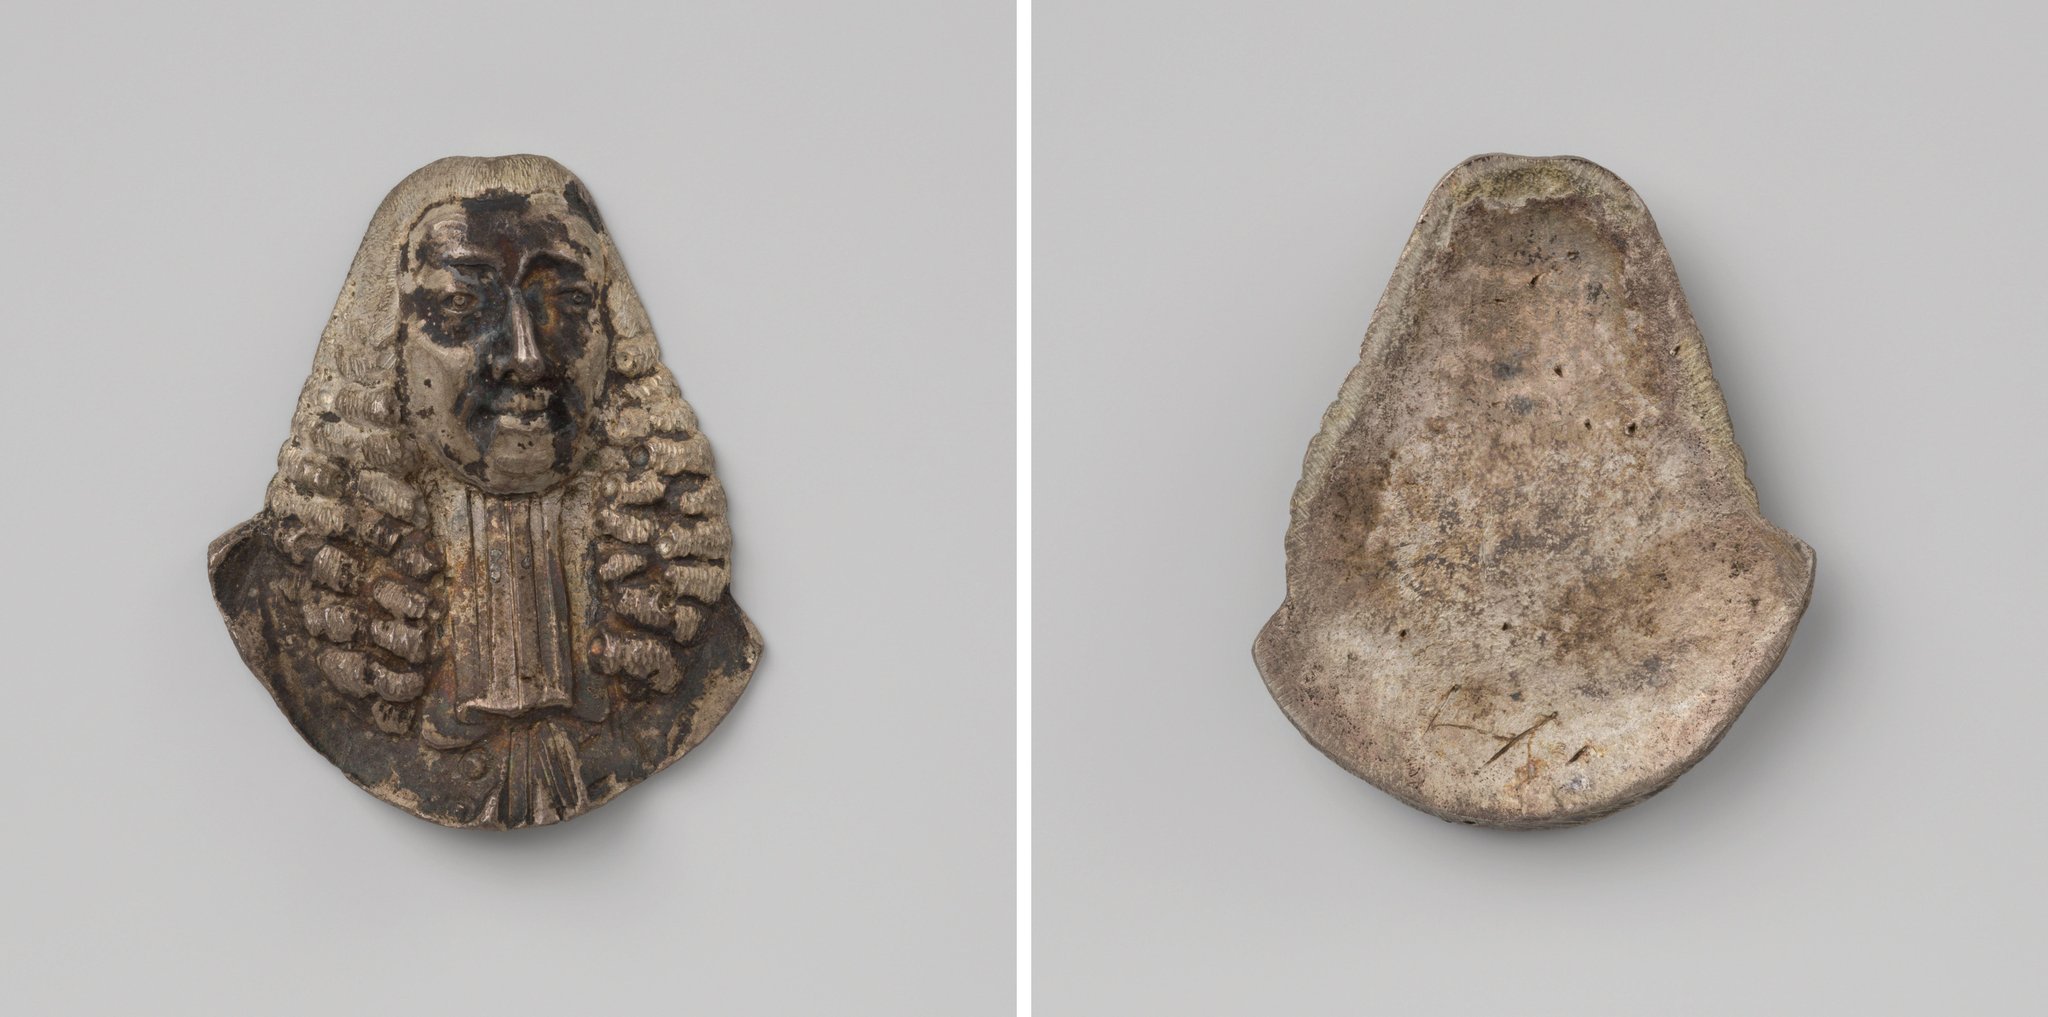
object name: insignia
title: Hendrik Danielsz. Hooft, burgemeester van Amsterdam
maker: Anonymous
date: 1787-1795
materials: silver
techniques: repoussé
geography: netherlands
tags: amsterdam, mayor, hendrik danielsz. hooft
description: Eenzijdig zilveren draagteken in vorm van mannenbuste. Voorzijde: borststuk man. Keerzijde: blanco